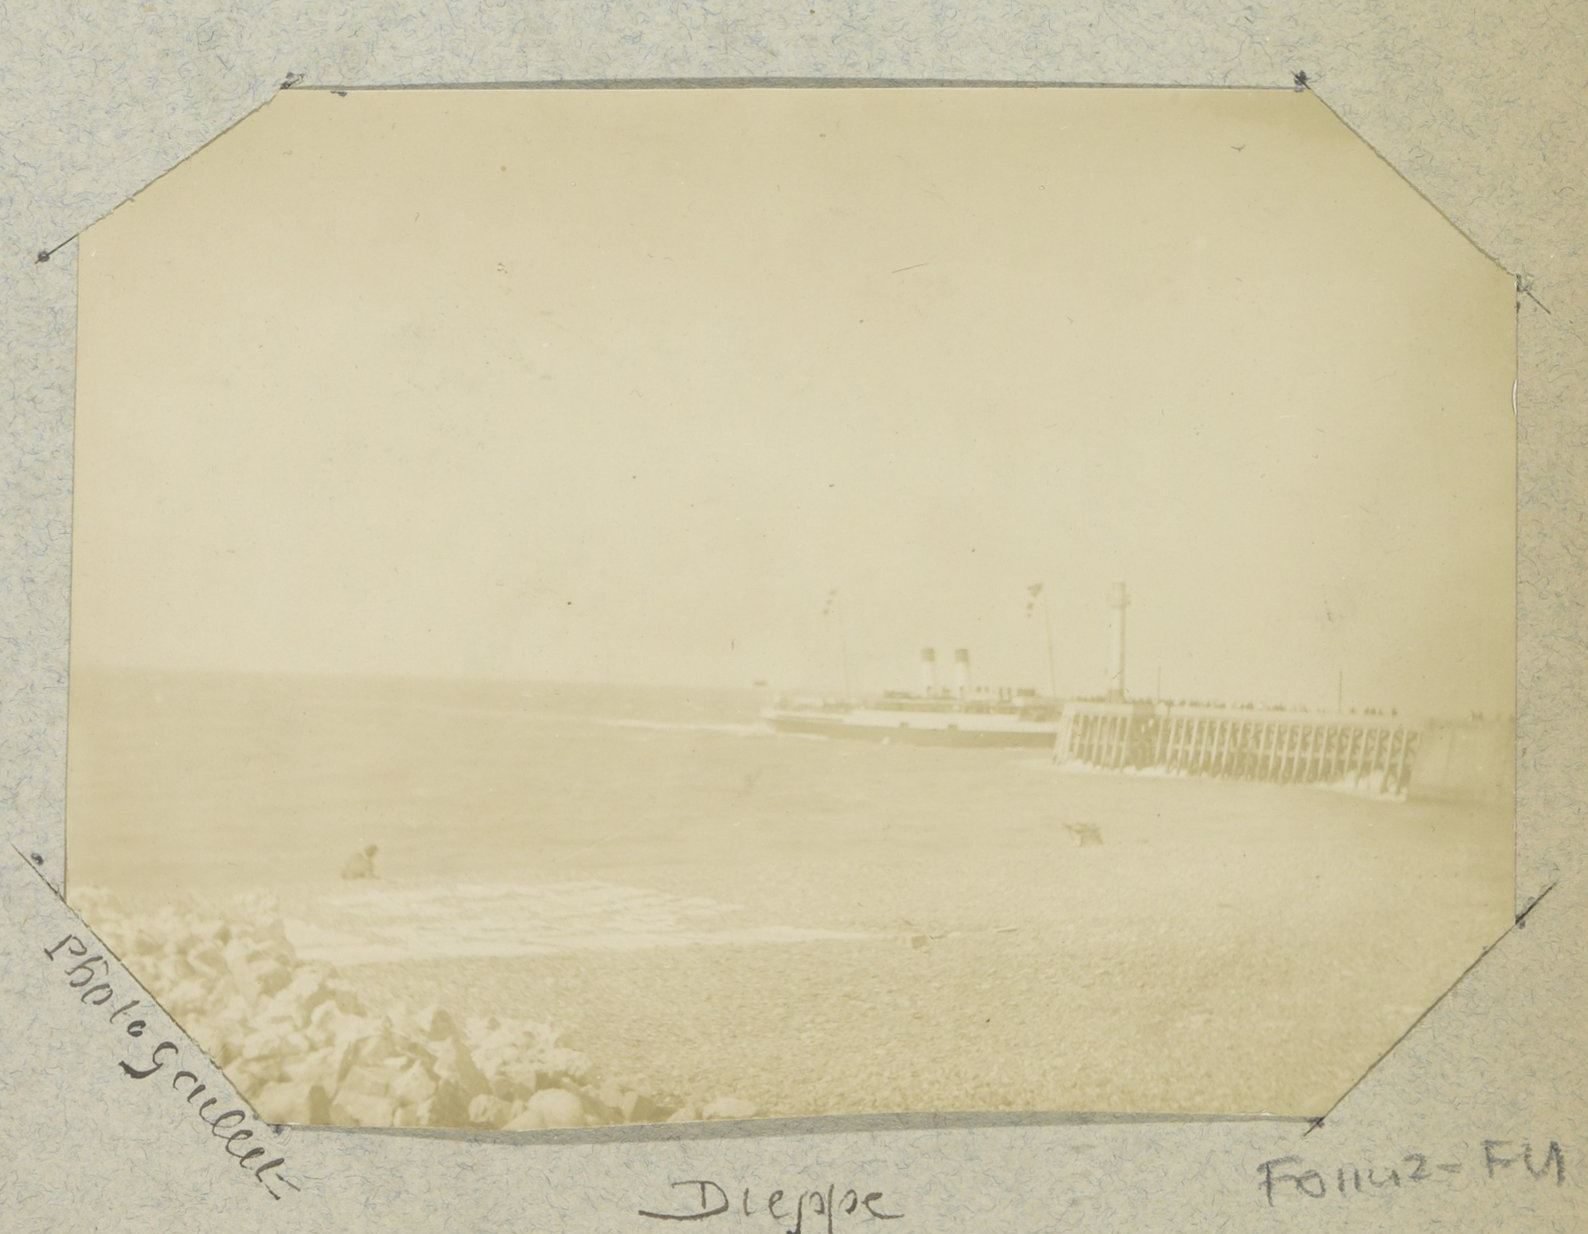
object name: photograph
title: Strand bij Dieppe met op de achtergrond een binnenvarend schip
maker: gaillet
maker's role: amateurfotograaf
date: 1890-1900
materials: paper, photographic support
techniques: daylight paper print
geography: dieppe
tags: beach, steamship, motorship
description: Onderdeel van Album van een Franse amateur met foto's van Frankrijk, Algerije, Palmyra, de Wereldtentoonstelling van 1900 en van bekende Fransen.